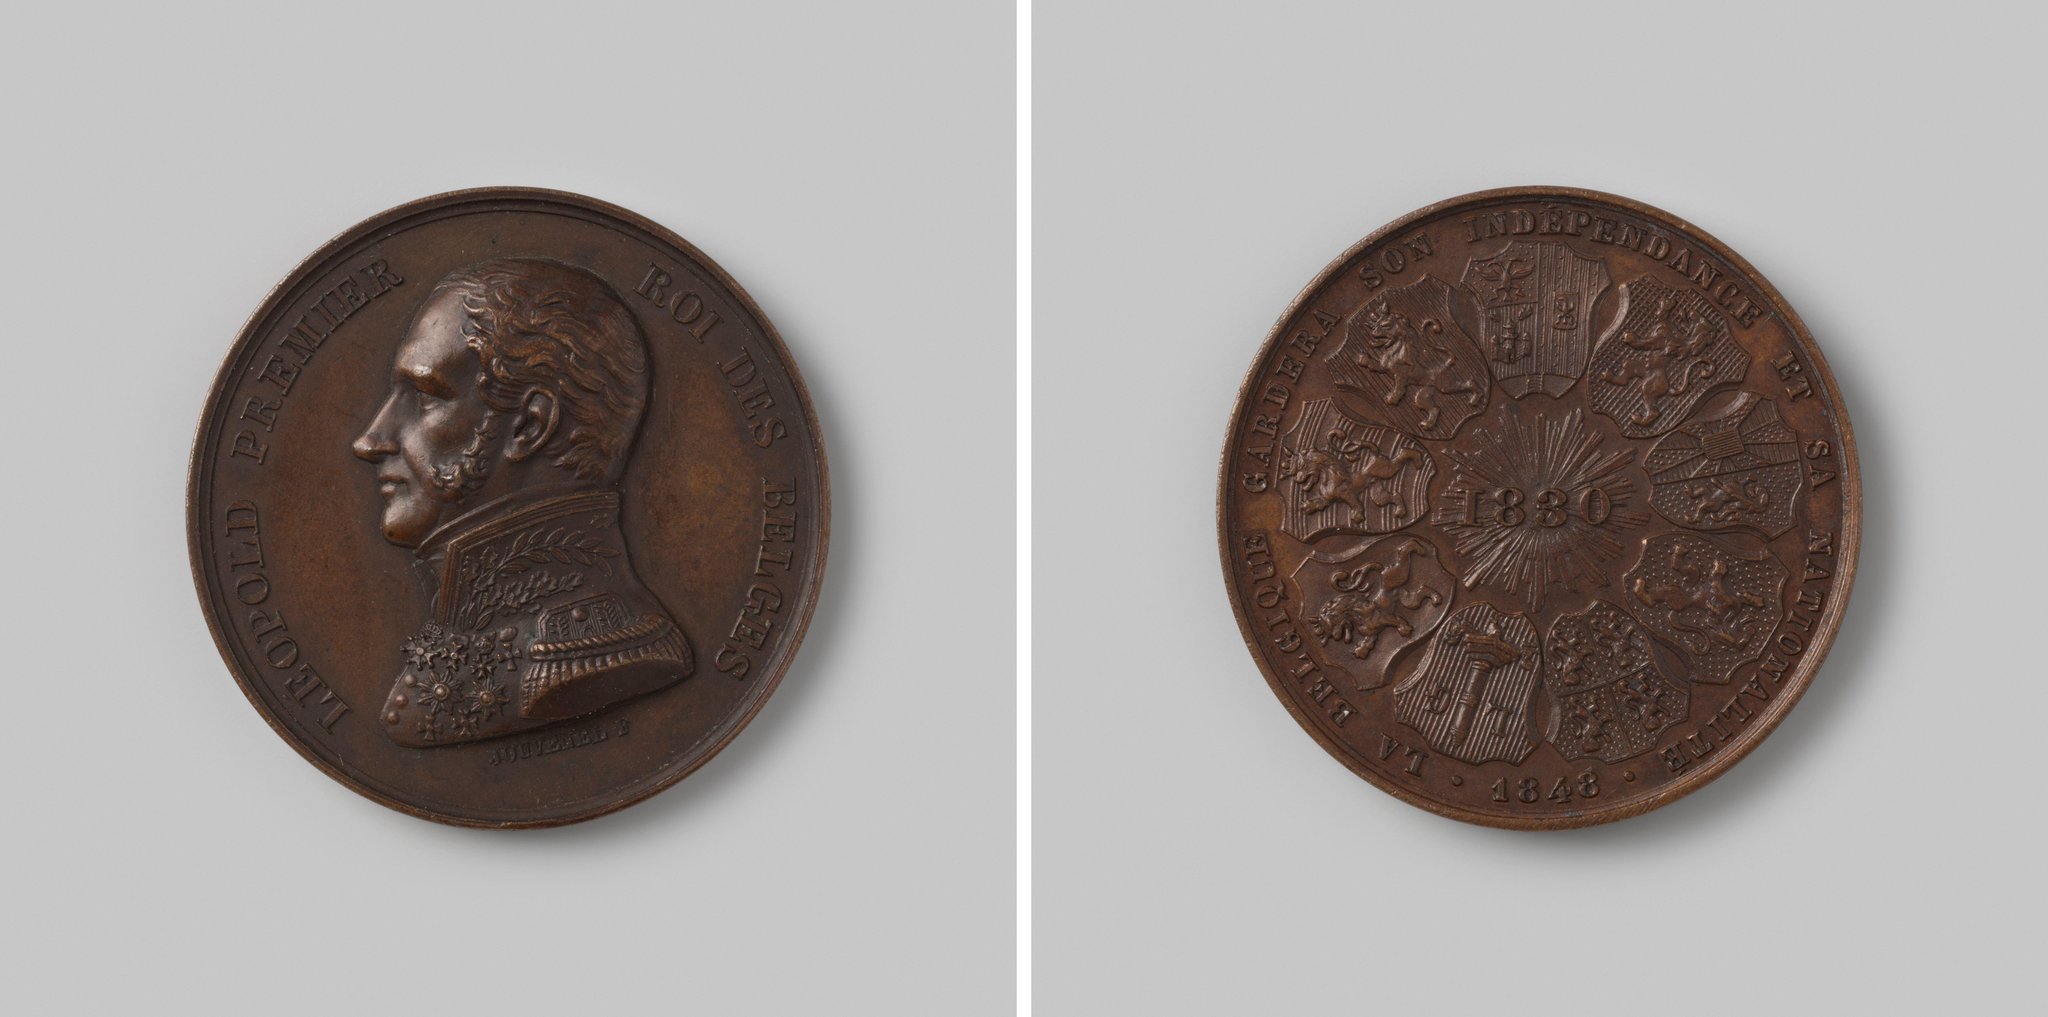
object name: history medal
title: België behoudt haar onafhankelijkheid in 1848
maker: adolphe jouvenel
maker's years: 1798-1867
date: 1848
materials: bronze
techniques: striking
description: Bronzen penning, op de voorzijde het borstbeeld van Koning Leopold I naar links met omschrift, op de keerzijde het stralende jaartal 1830 binnen een kring van negen wapenschilden, met omschrift.